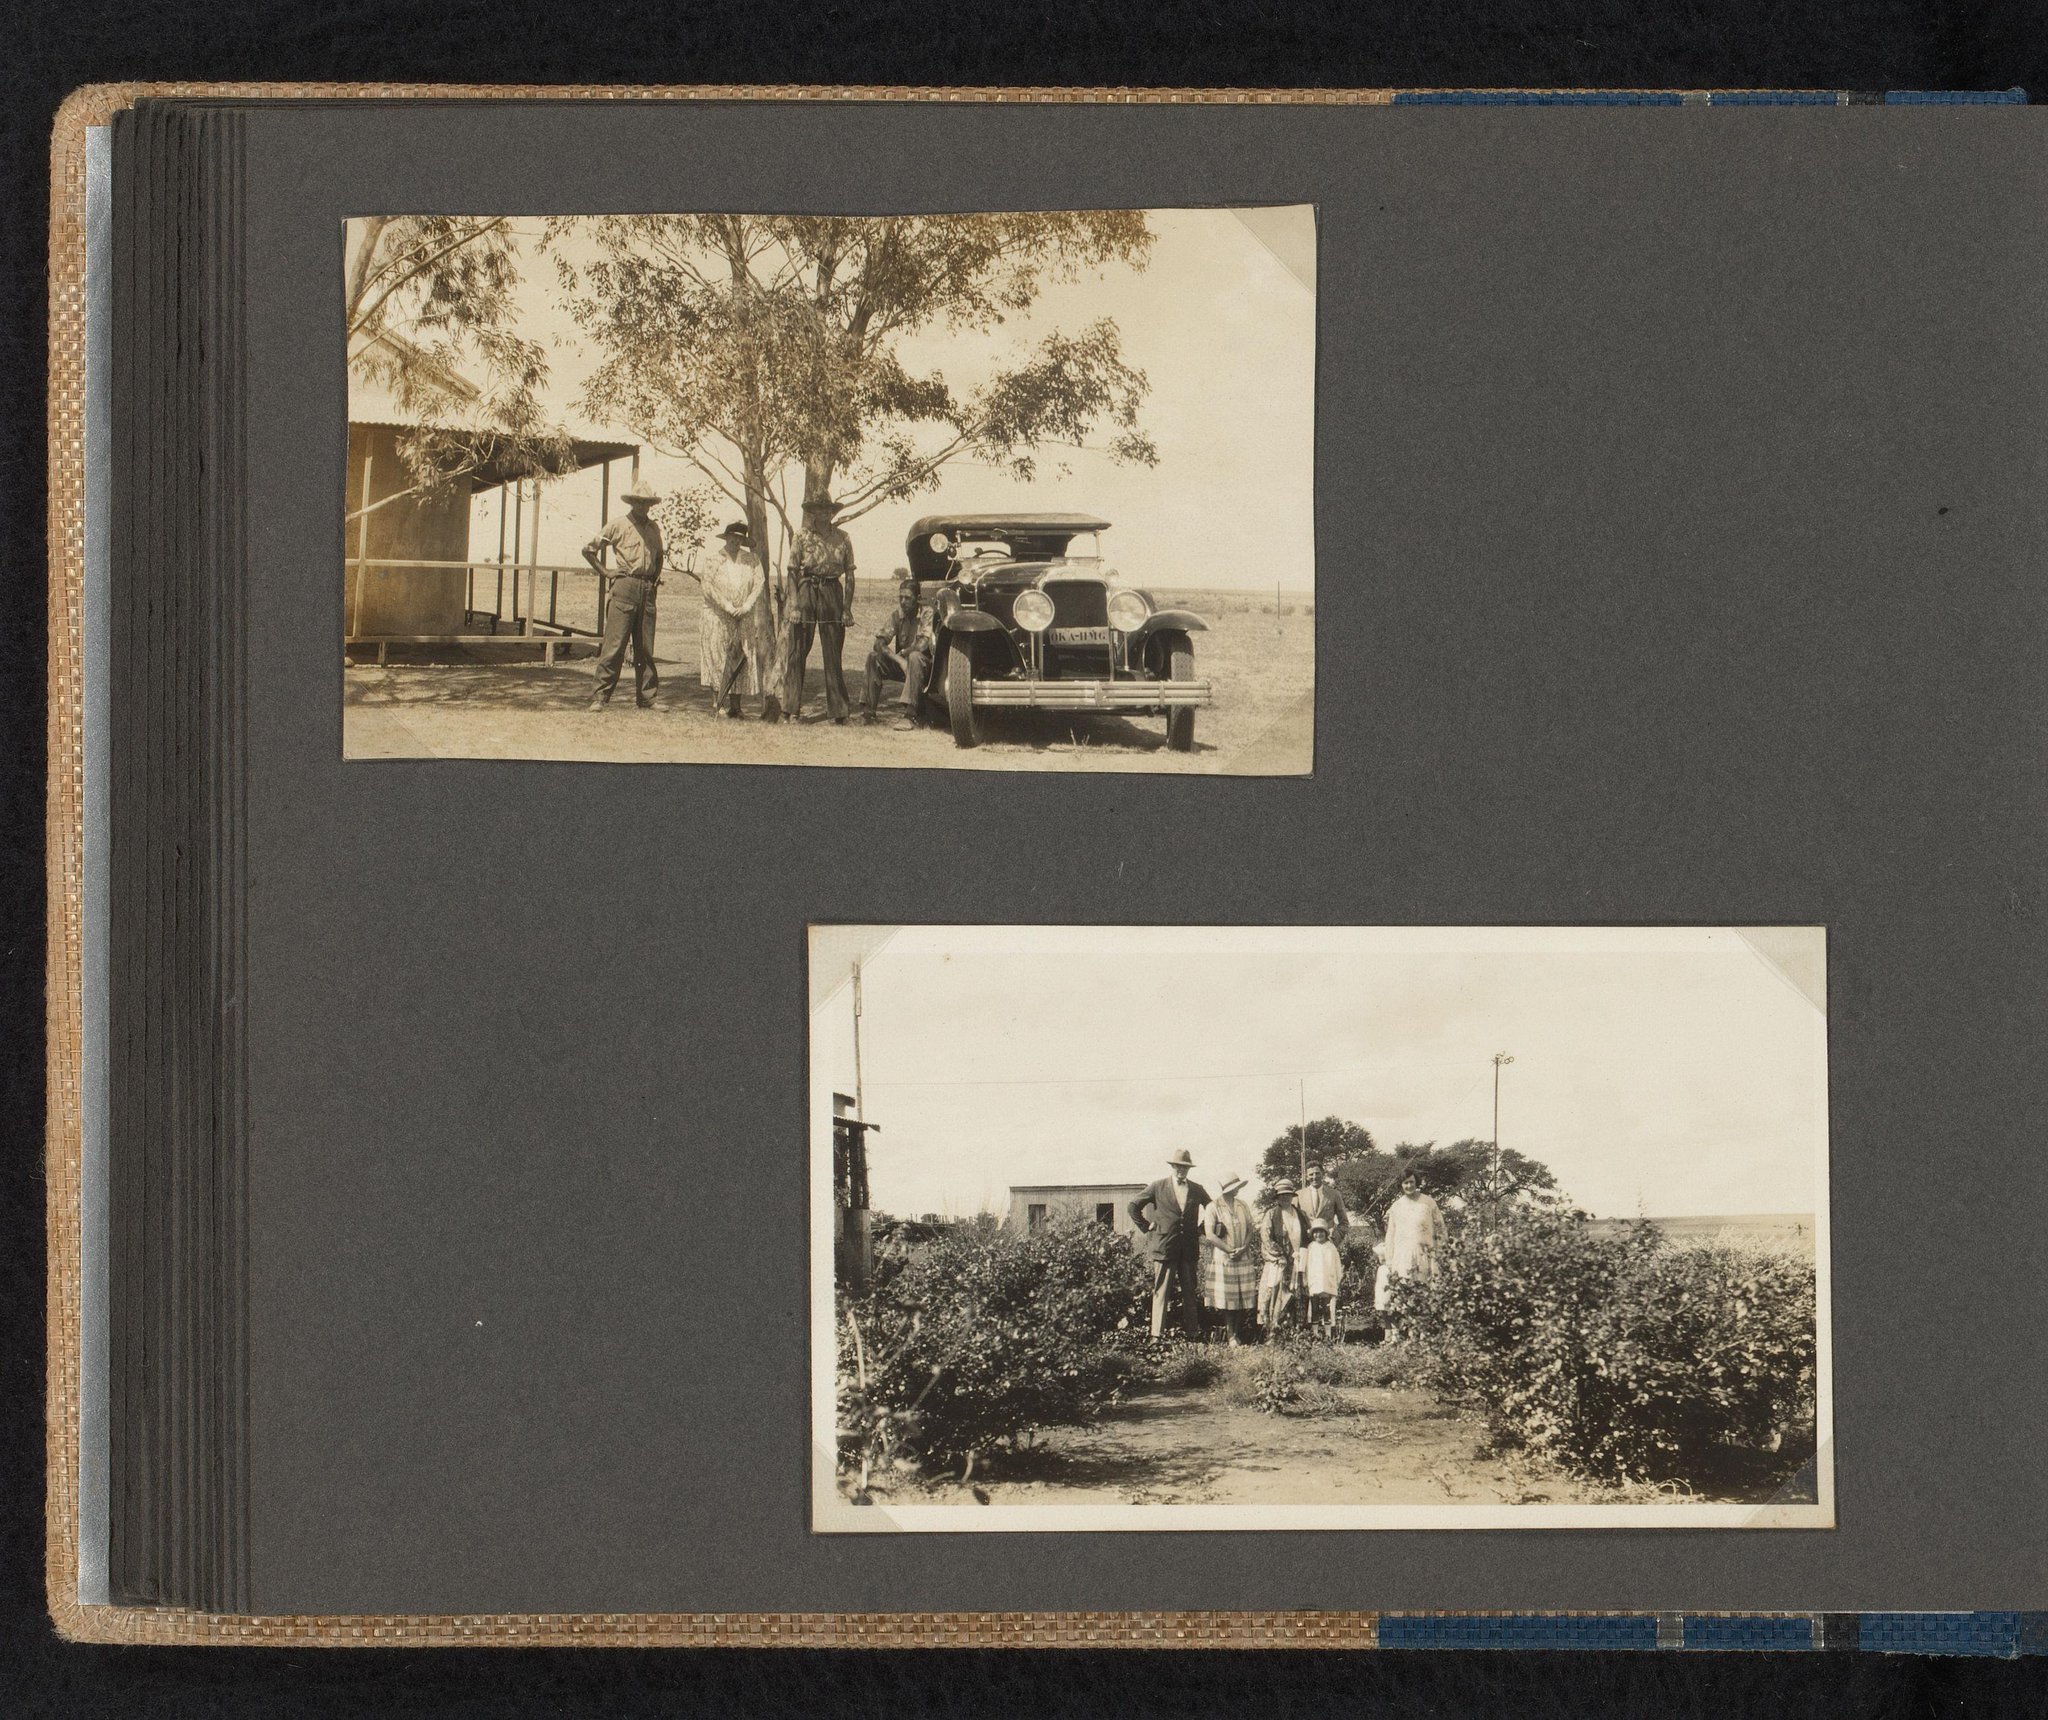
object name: album leaf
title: Groepsportretten, met Arendina van den Berg, bij een woning in Zuid-Afrika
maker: karel frederik van den berg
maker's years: 1873-1948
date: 1920-1930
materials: paper, cardboard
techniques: gelatin silver print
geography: south africa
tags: arendina charlotte marie van den berg-geertsema, rural housing, e.g. country-house, villa, cottage, anonymous historical persons portrayed in a group, in a group-portrait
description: Deze foto's zijn onderdeel van een album.